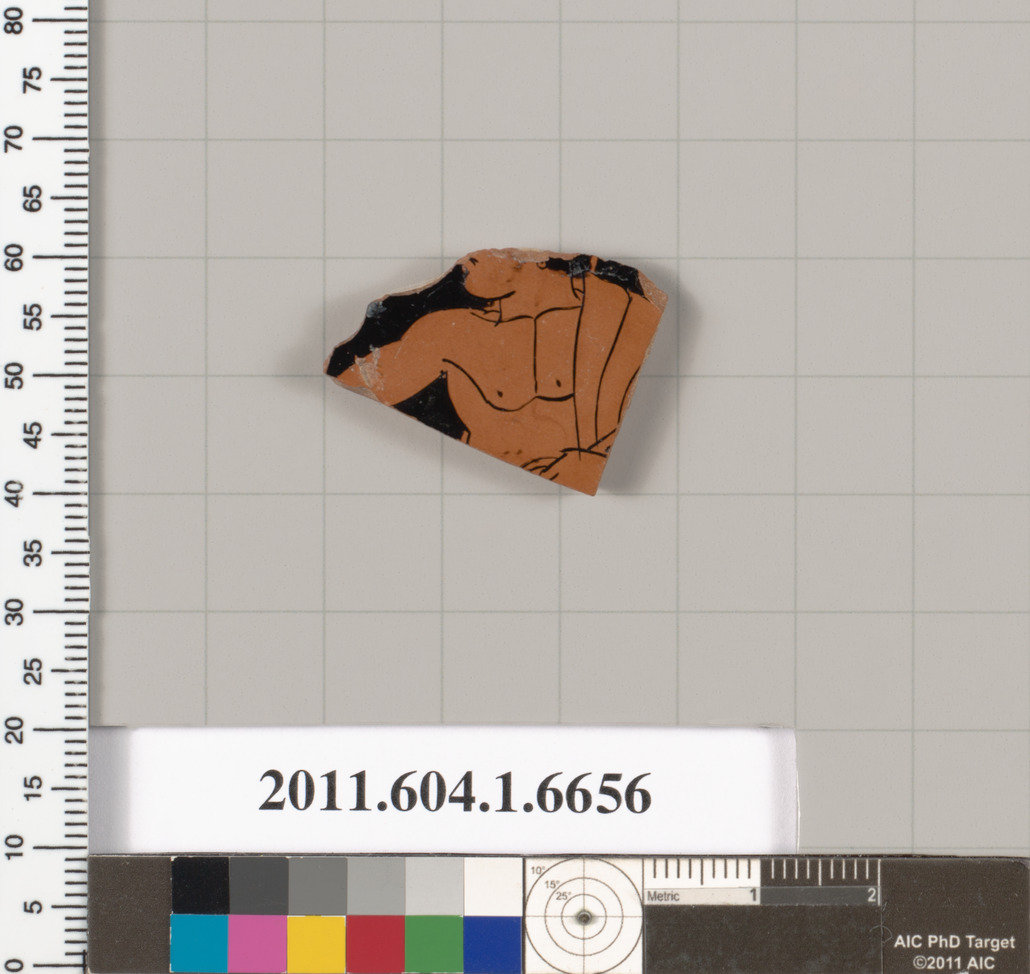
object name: kylix fragment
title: Terracotta fragment of a kylix (drinking cup)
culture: greek, attic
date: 490-470 BCE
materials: terracotta